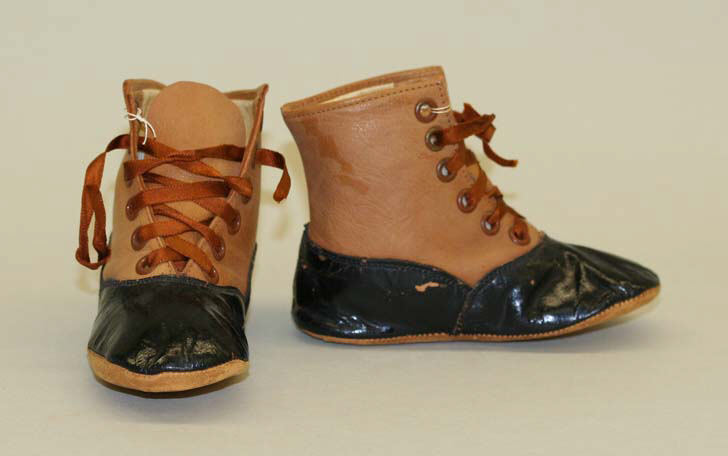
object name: boot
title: Boots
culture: american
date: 1900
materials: leather, silk